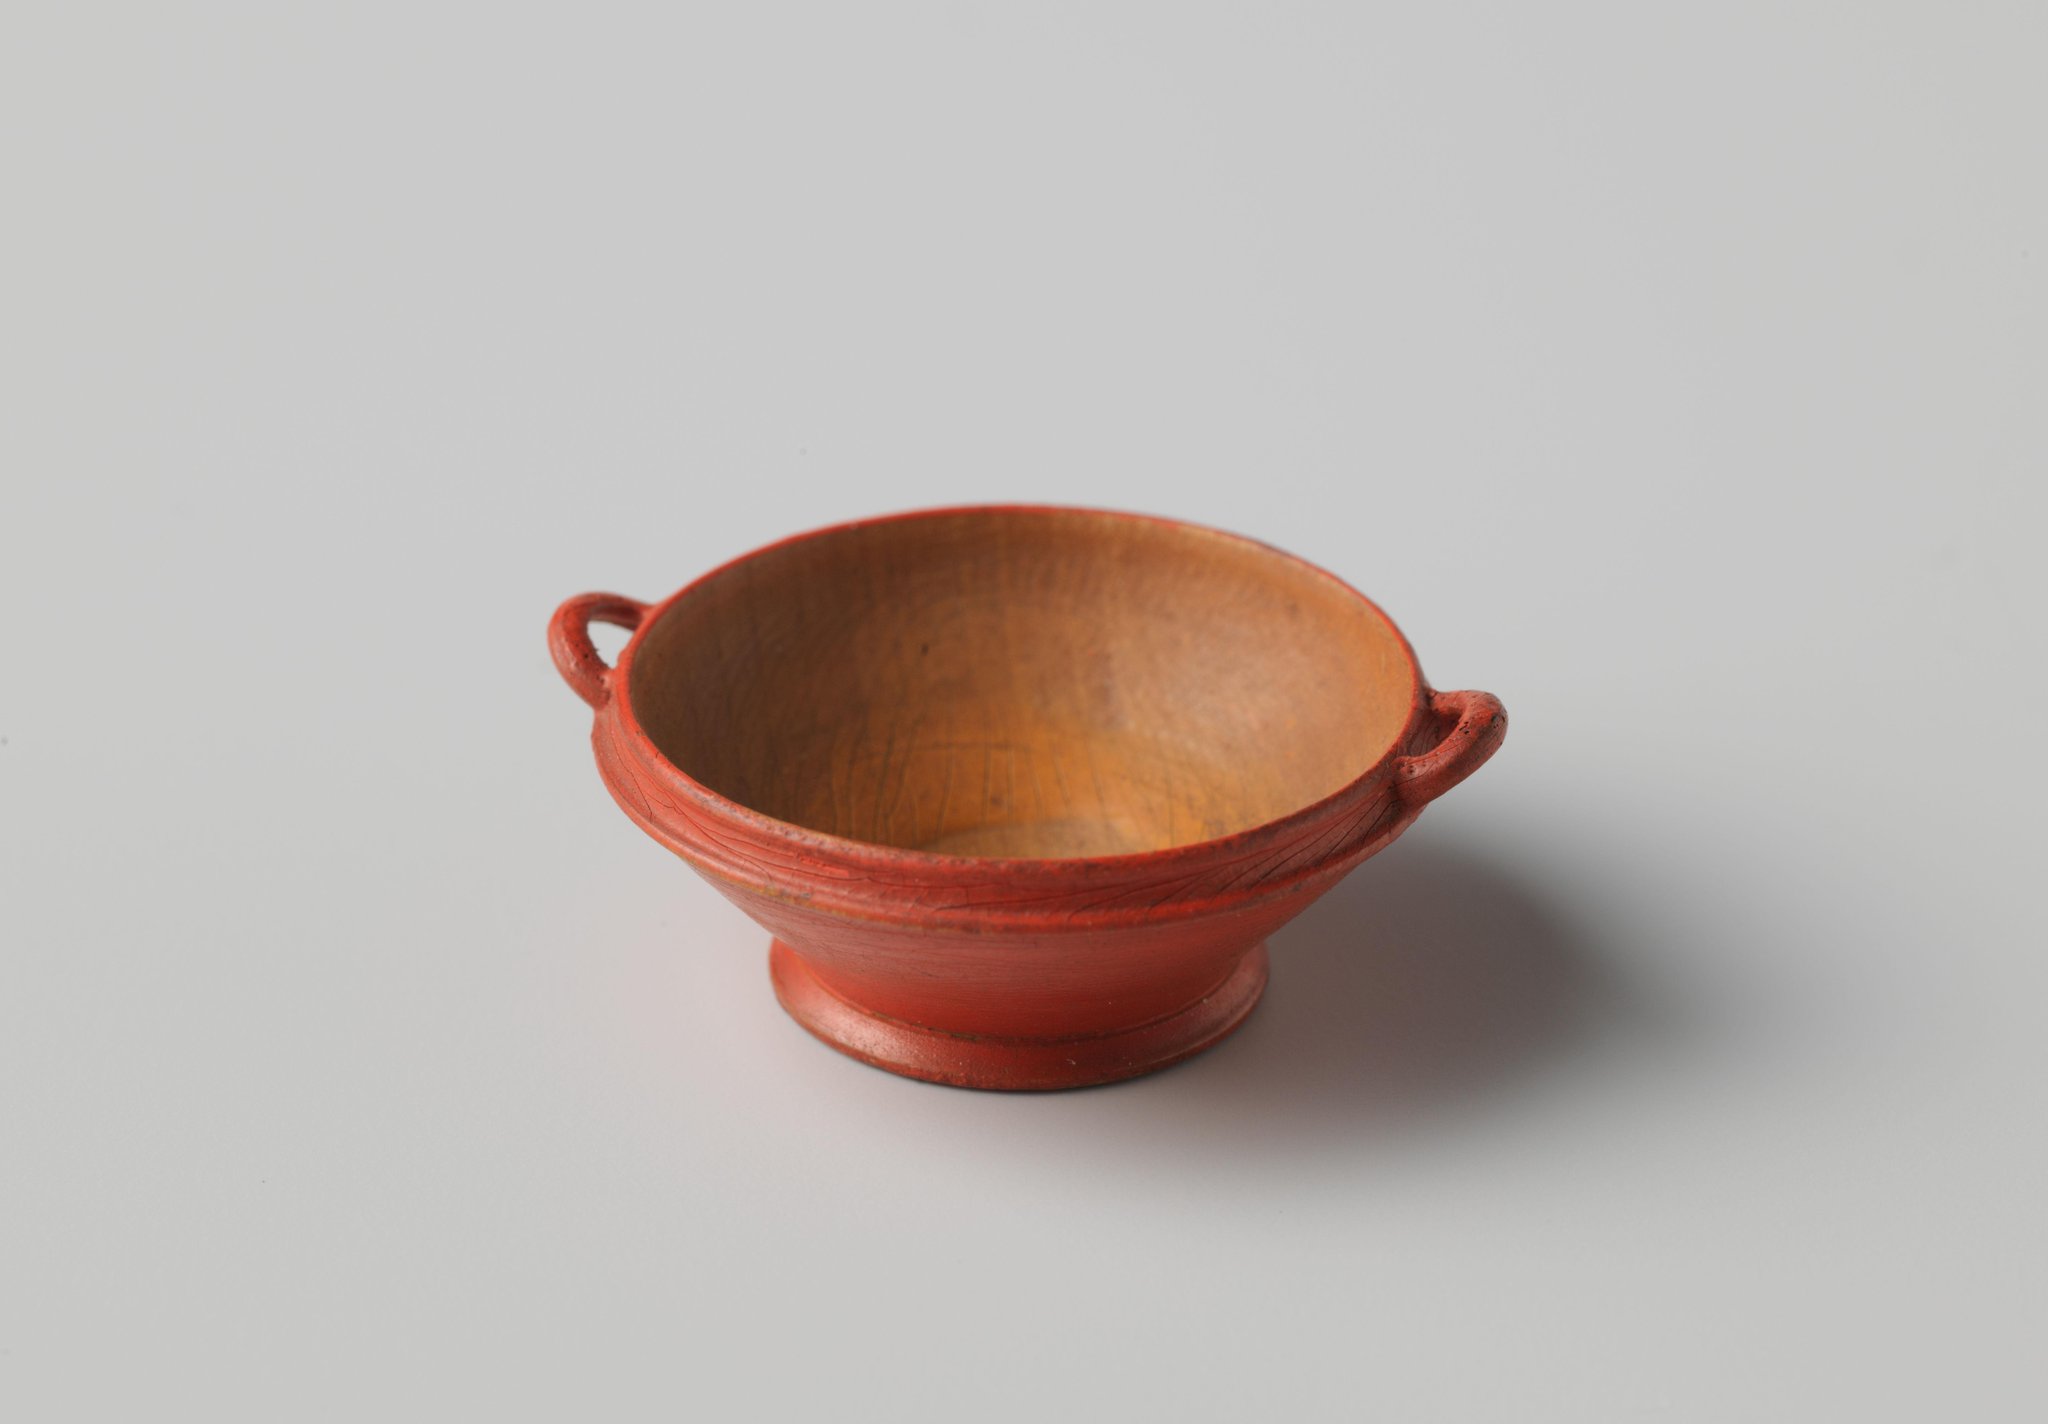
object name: miniature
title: Schaal met twee oren op standring, roodgeverfd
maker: Anonymous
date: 1675-1700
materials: wood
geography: amsterdam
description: Schaal, gedraaid van hout op standring, met twee oren, van buiten roodgeverfd.